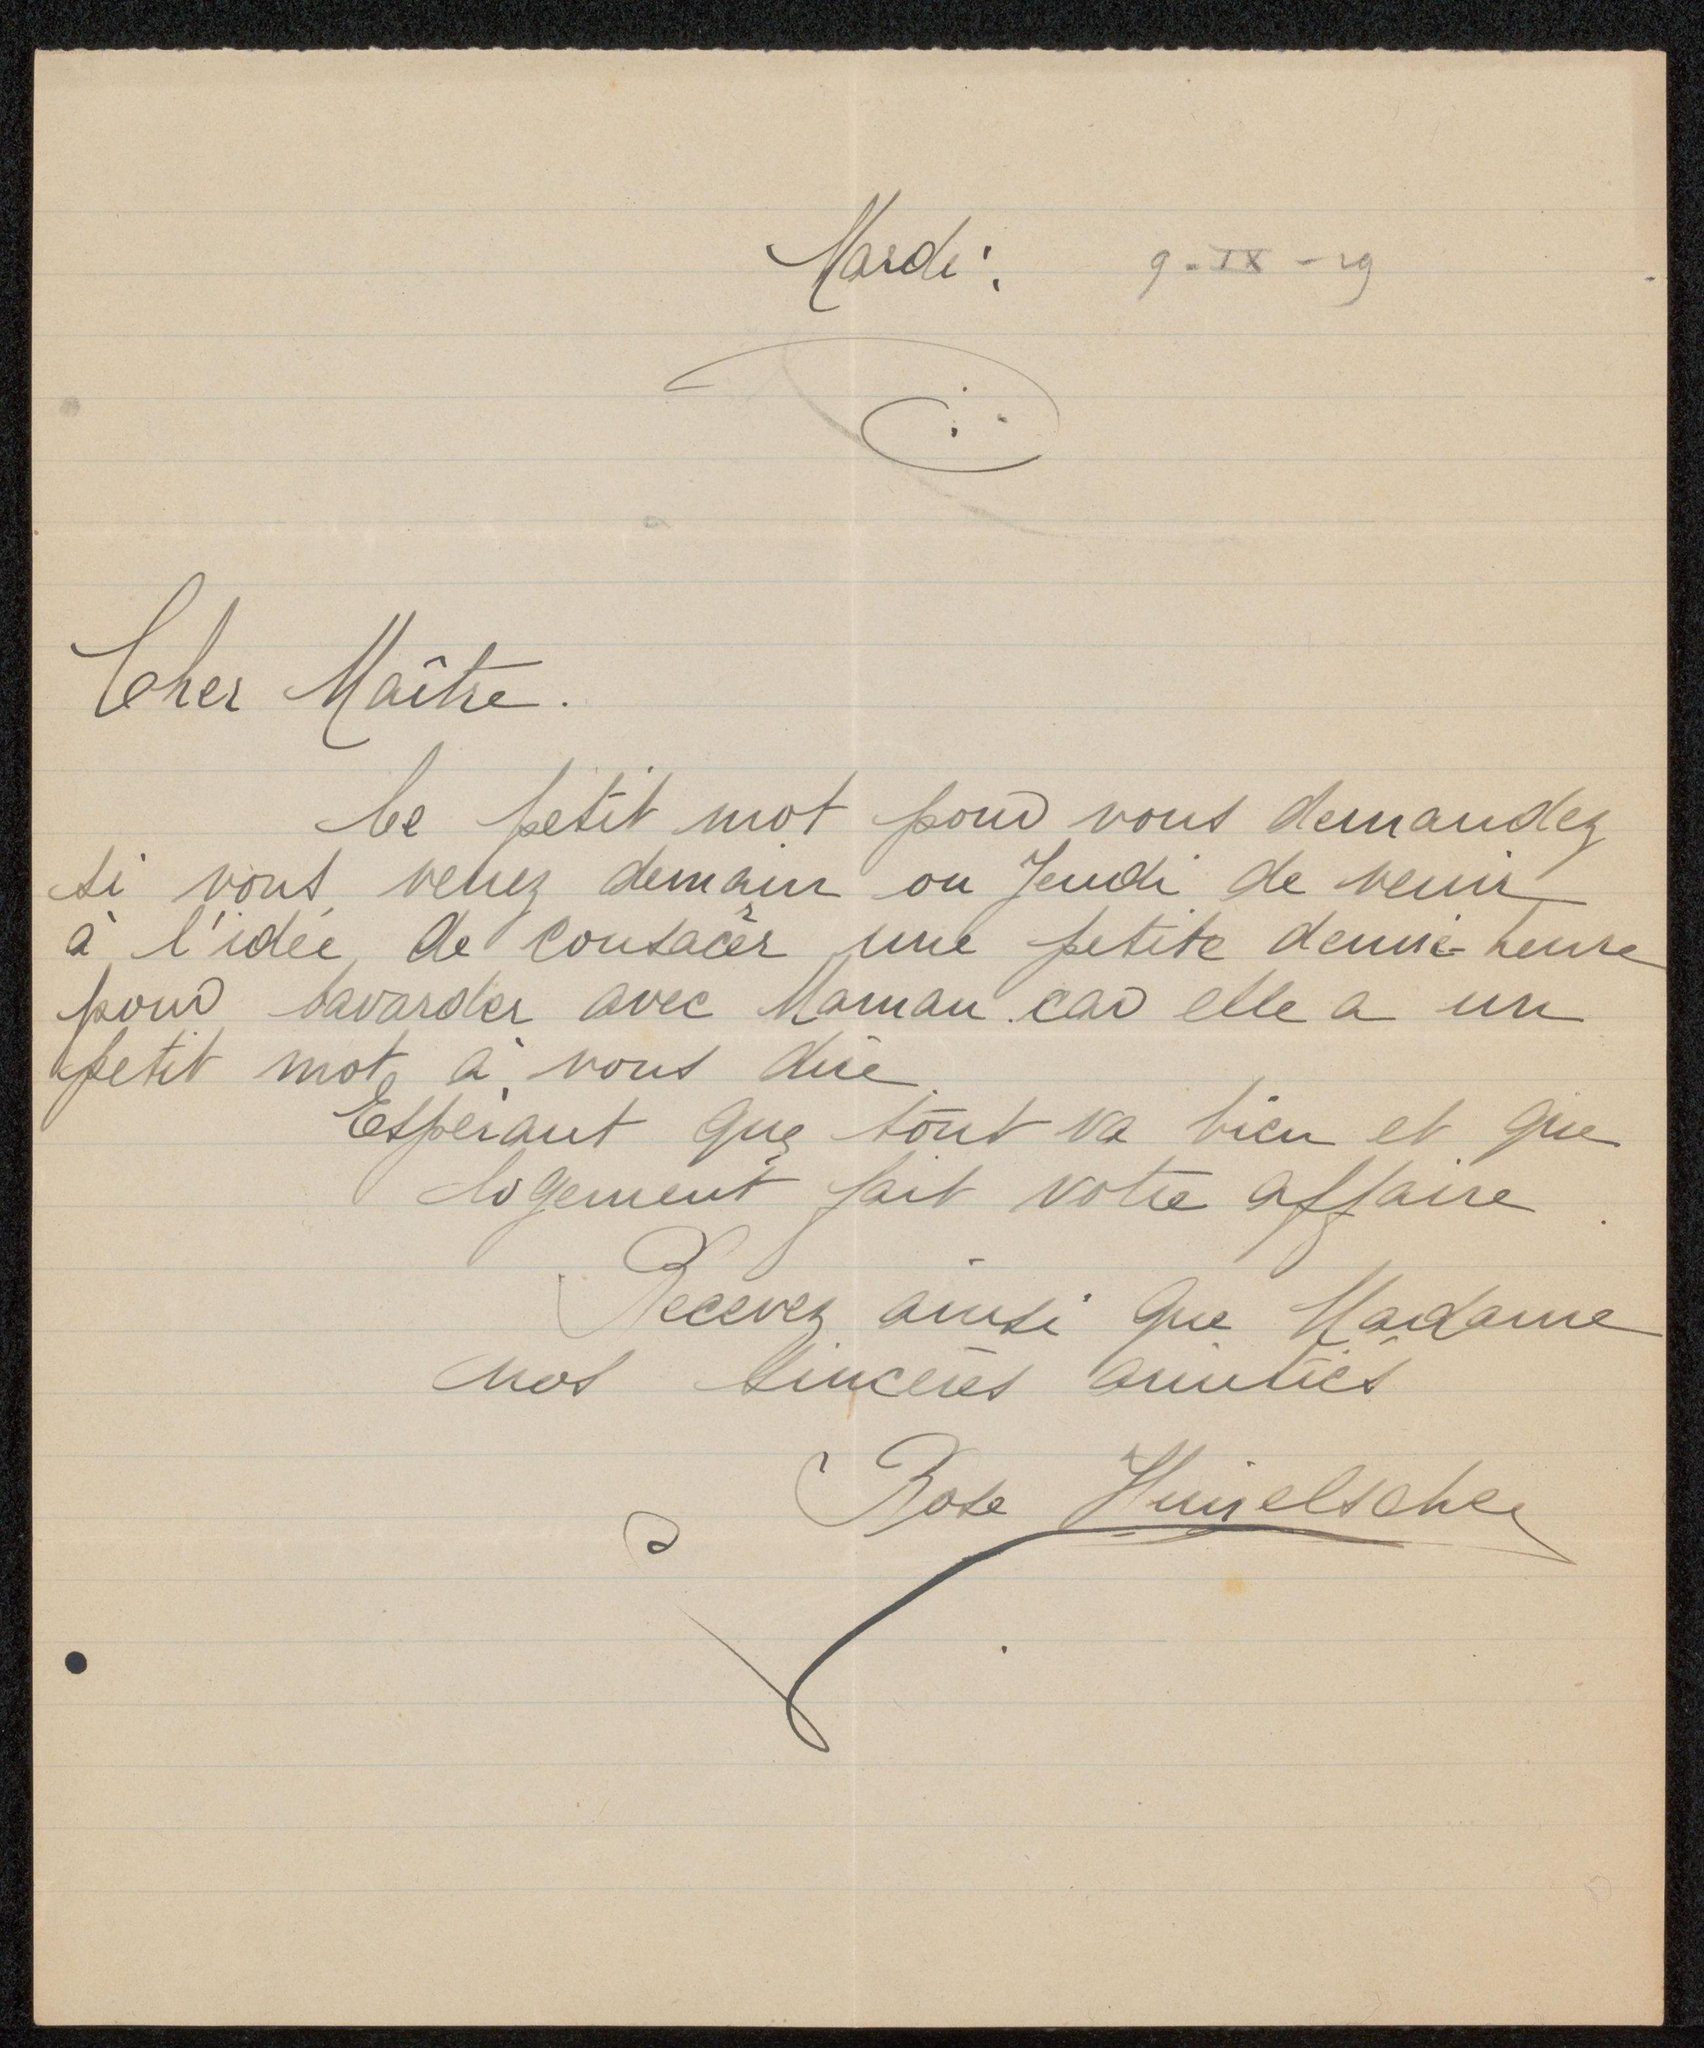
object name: letter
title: Brief aan Philip Zilcken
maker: rose imel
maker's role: draughtsman, painter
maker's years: 1901-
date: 1911-1930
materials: ink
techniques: pen, writing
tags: the hague, painter, philip zilcken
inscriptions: collector's mark: ‘RPK’